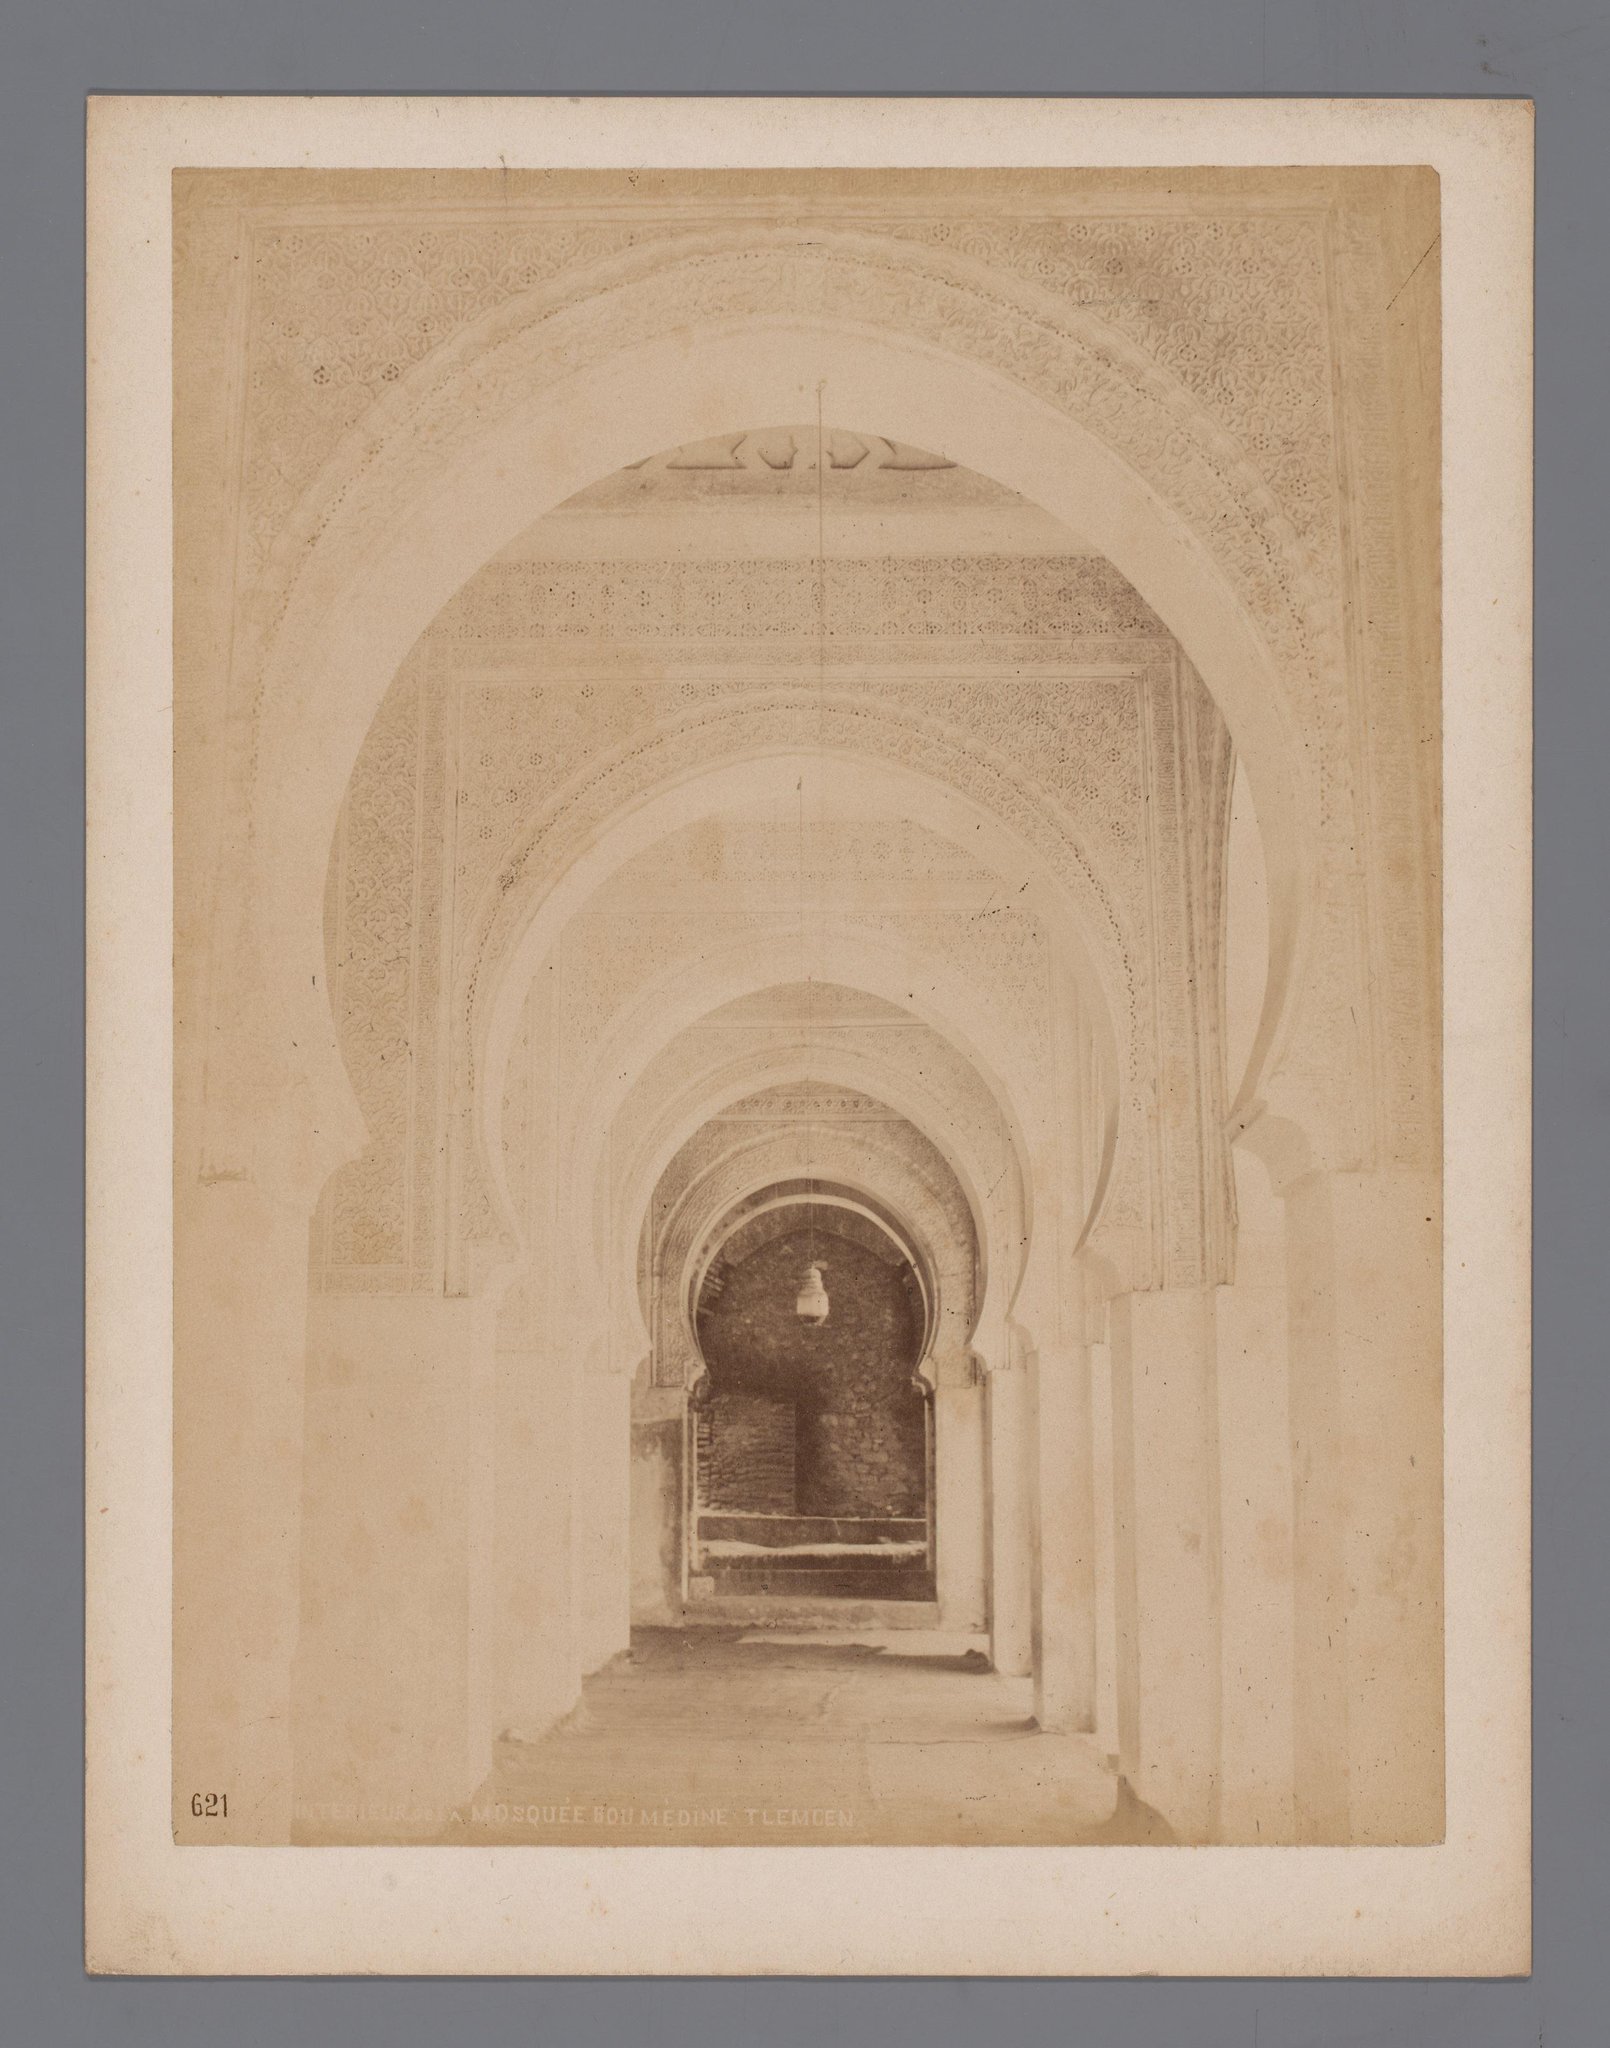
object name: photograph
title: Interieur van de Sidi Boumédienne moskee in Tlemcen, Algerije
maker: Anonymous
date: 1860-1900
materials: cardboard, paper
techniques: albumen print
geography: tlemcen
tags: temple, shrine ~ islam, mohammedanism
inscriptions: number: ‘621’